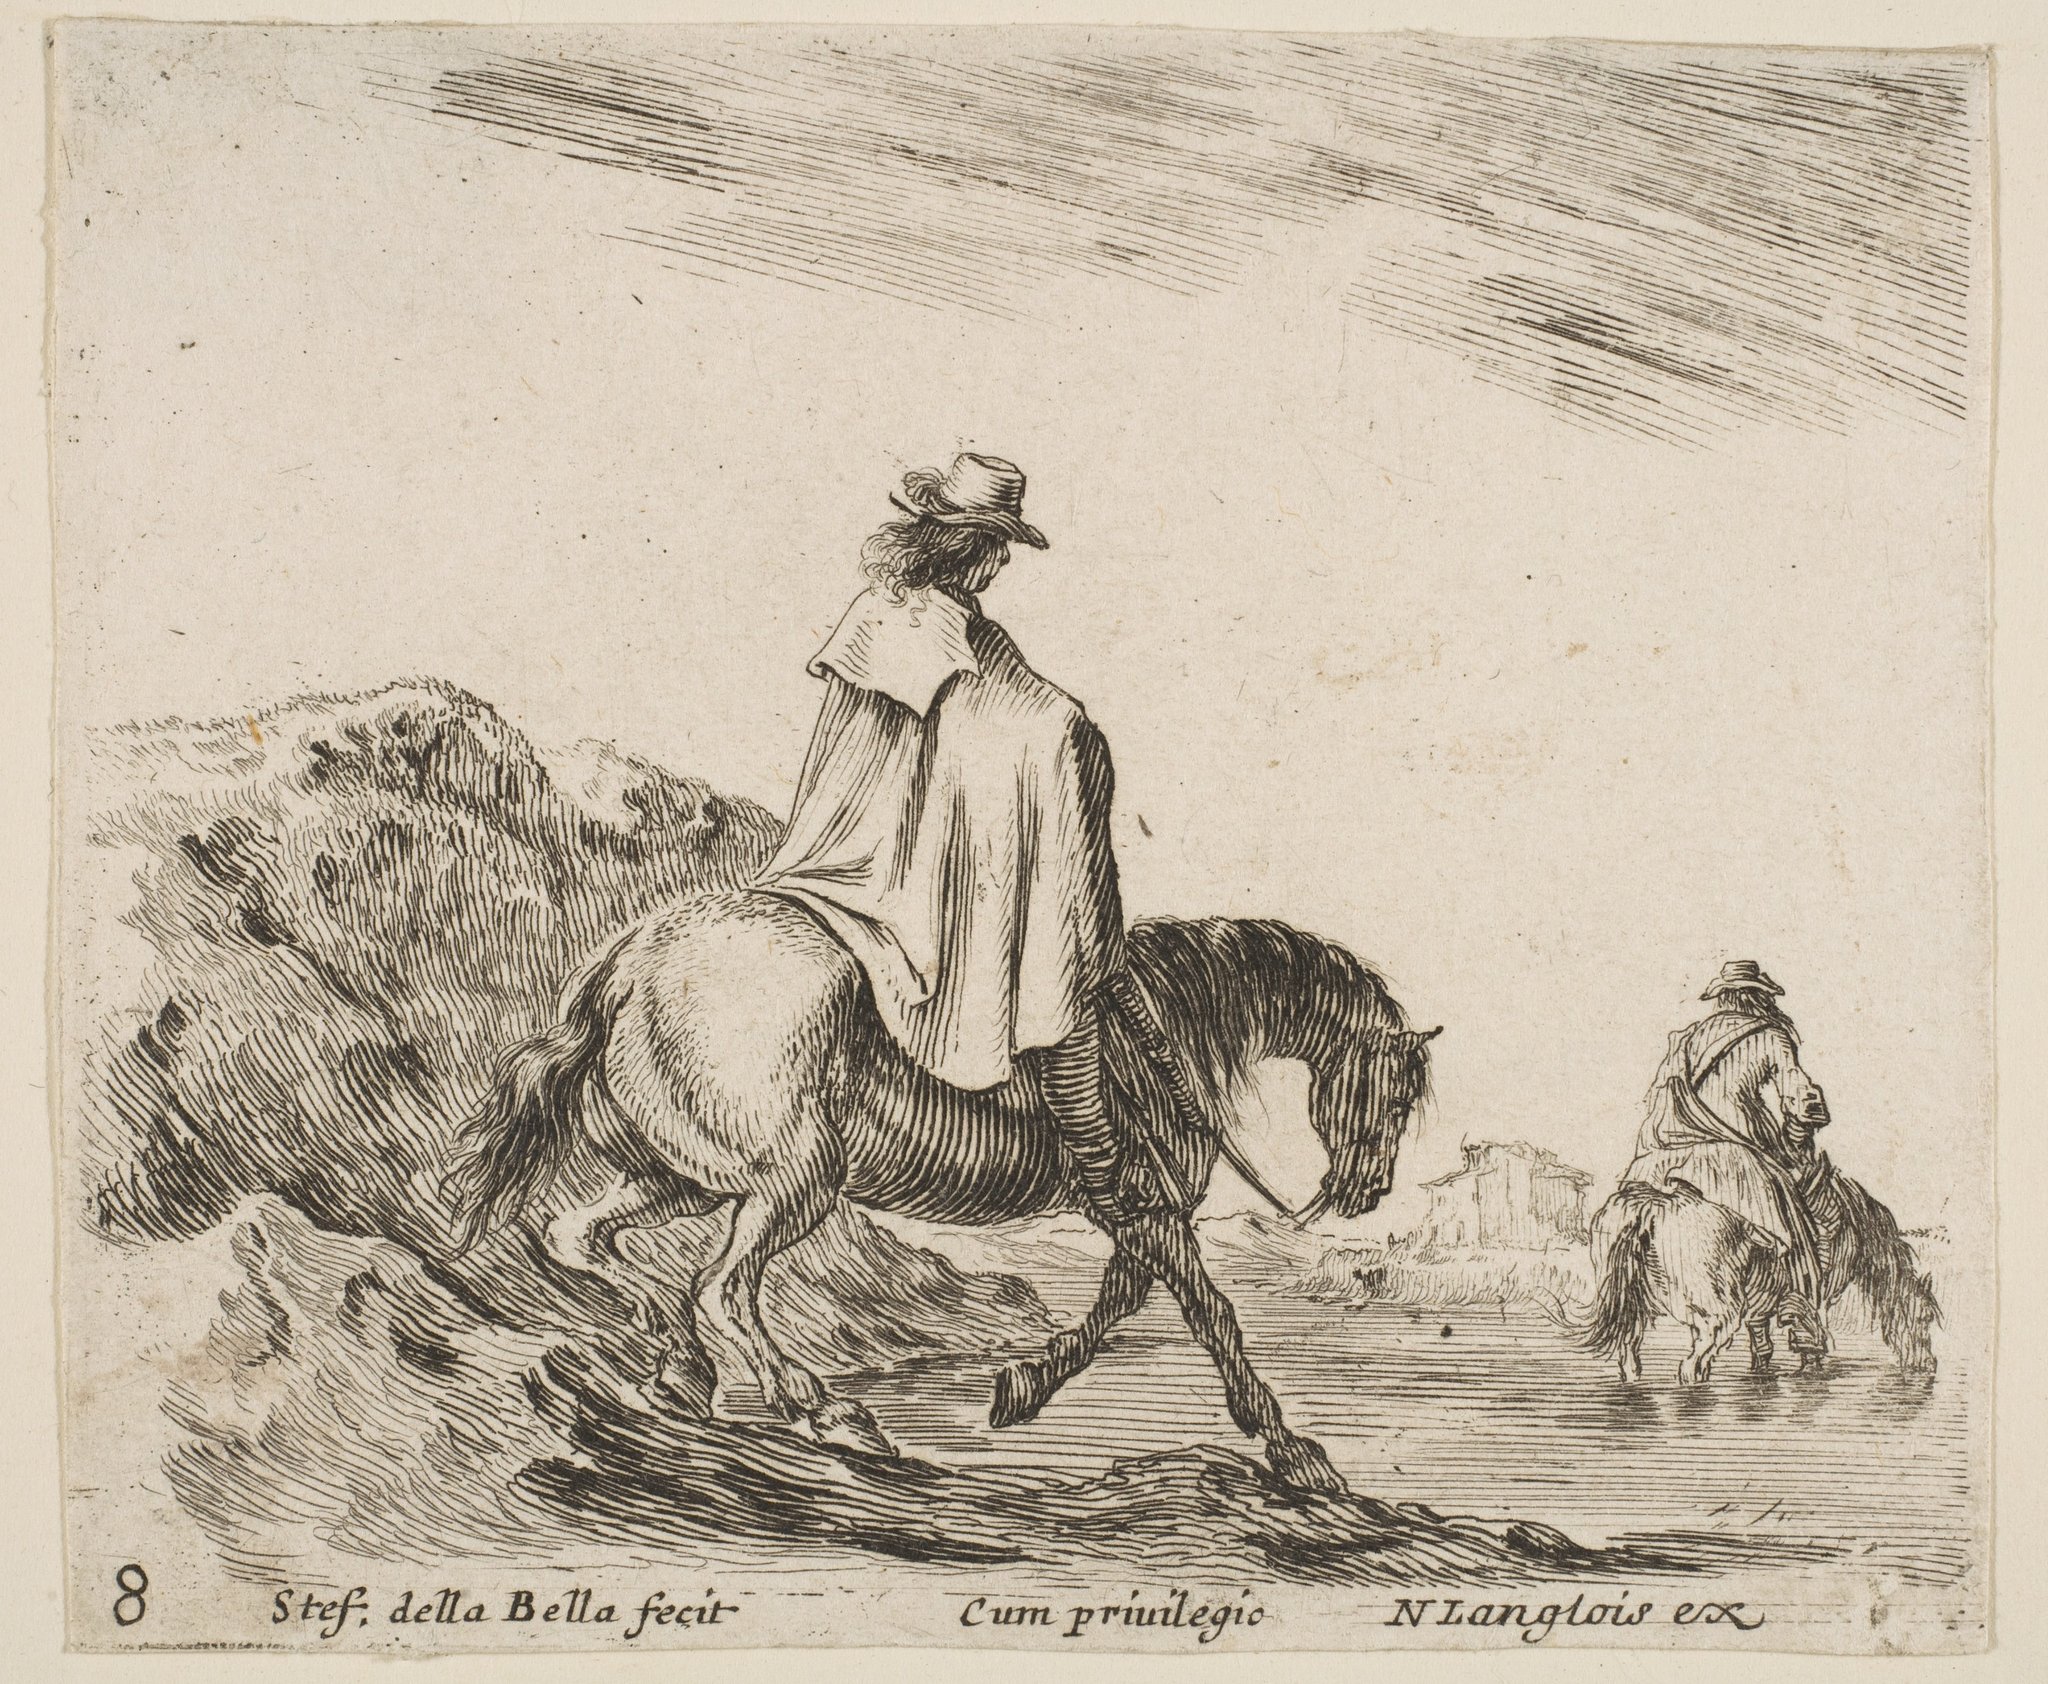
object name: print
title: A horseman descends a riverbank, another horseman in river to right, plate 8 from "Diversi capricci"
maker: stefano della bella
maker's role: artist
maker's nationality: italian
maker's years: 1610-1664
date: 1644-1647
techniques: etching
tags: men,horses